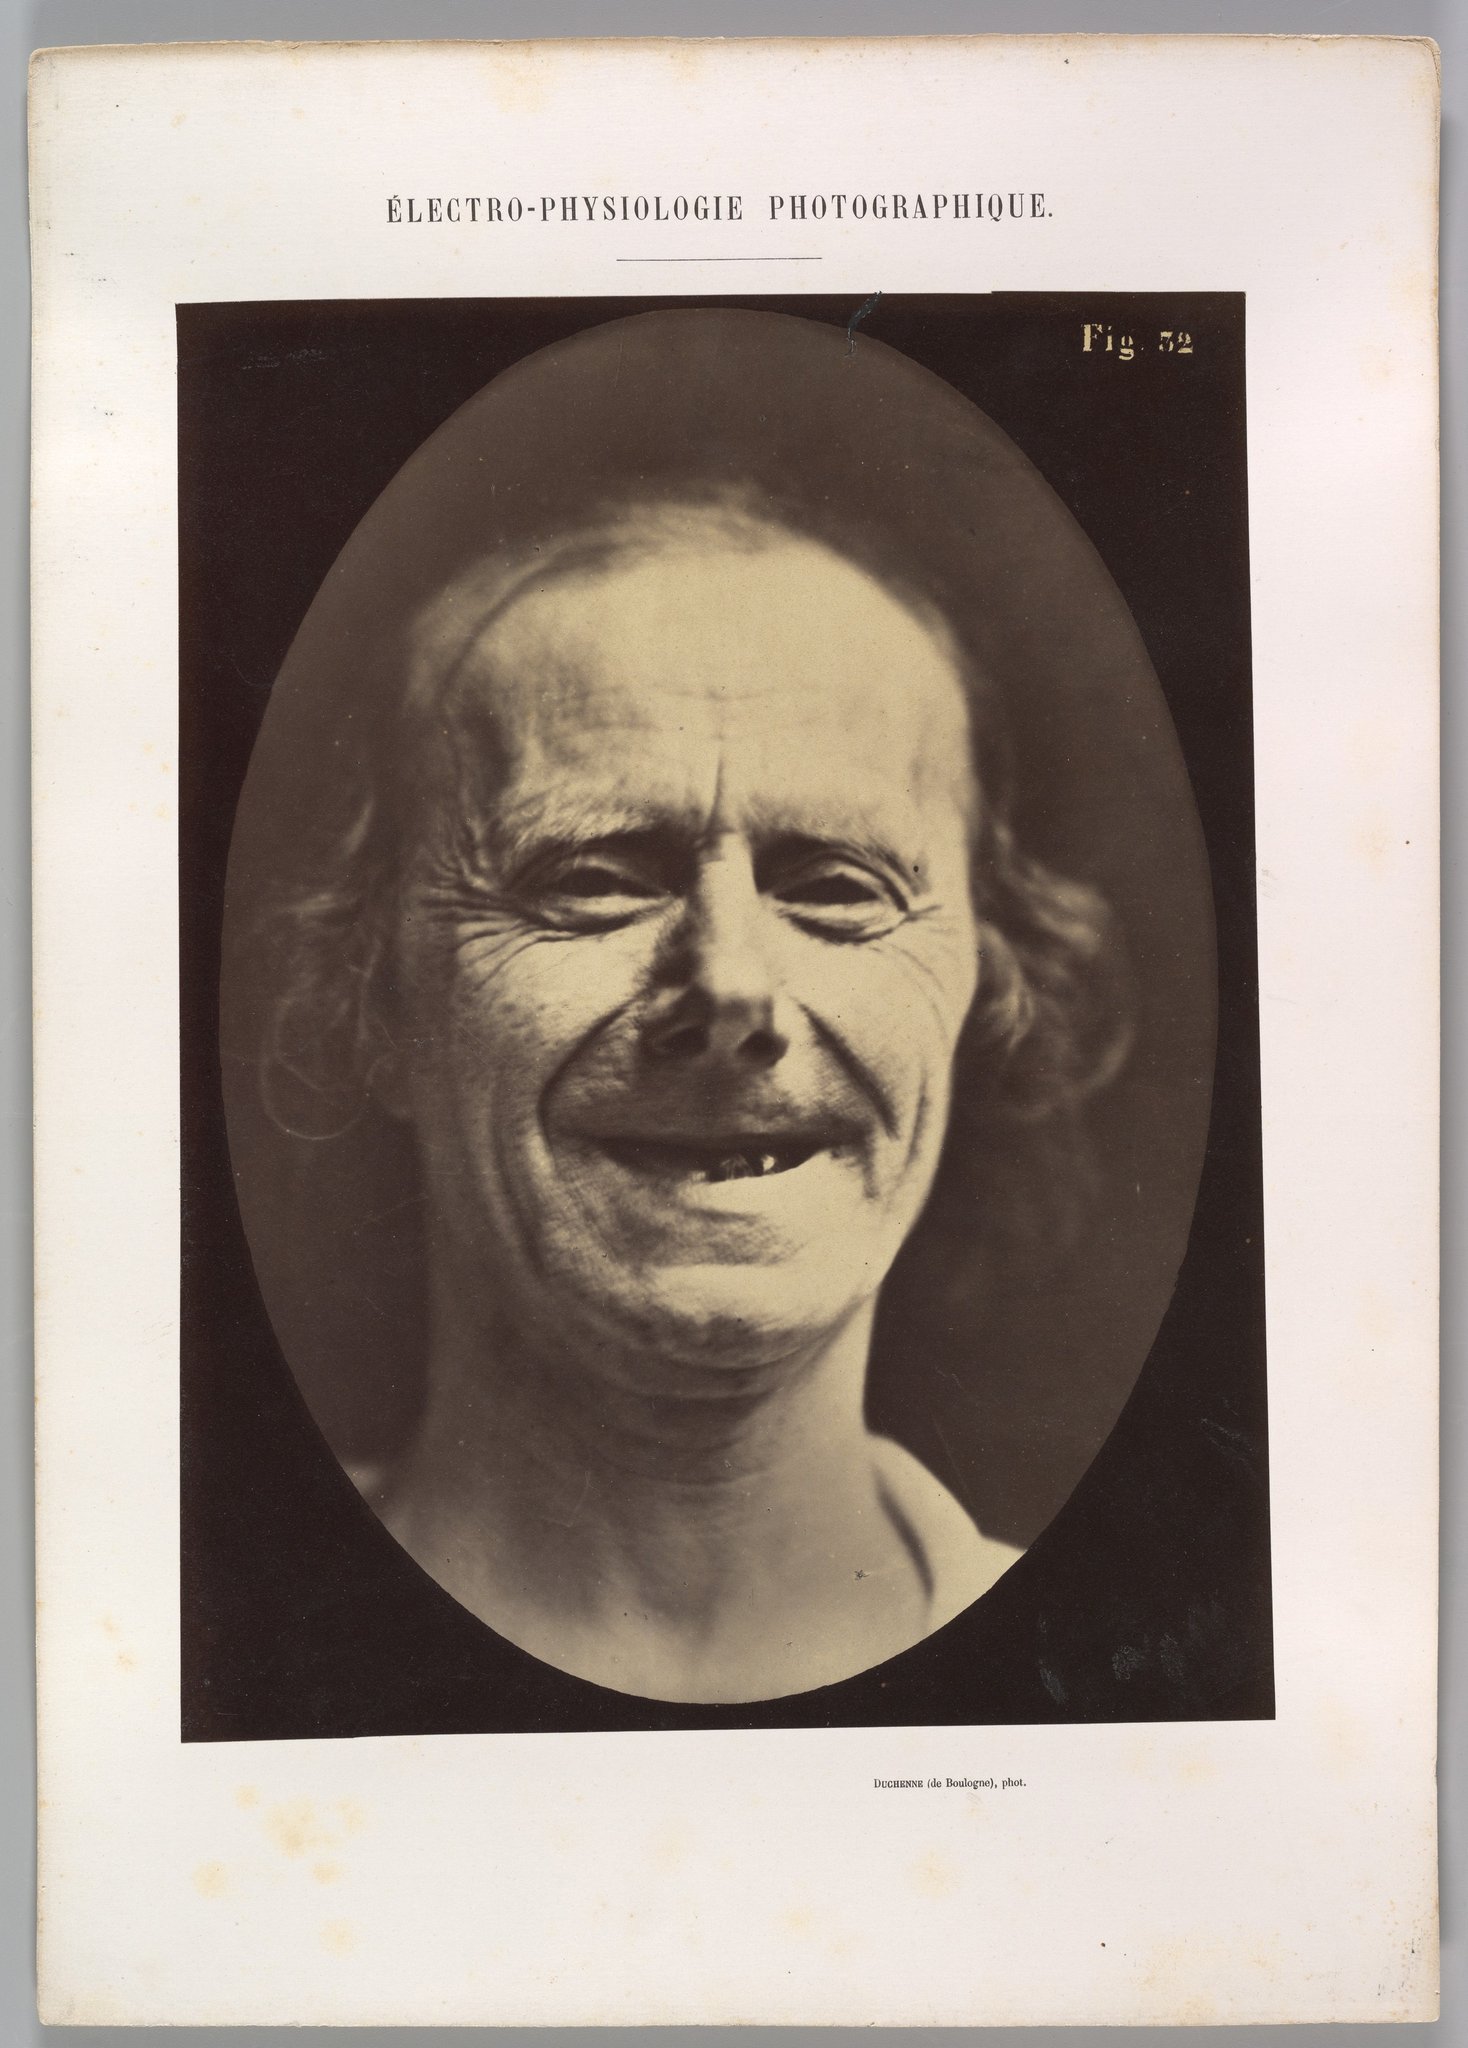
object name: photograph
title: Figure 52: Voluntary retraction of the lower lip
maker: guillaume-benjamin-amand duchenne de boulogne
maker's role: artist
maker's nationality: french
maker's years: 1806-1875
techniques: albumen silver print, glass negative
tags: men,portraits